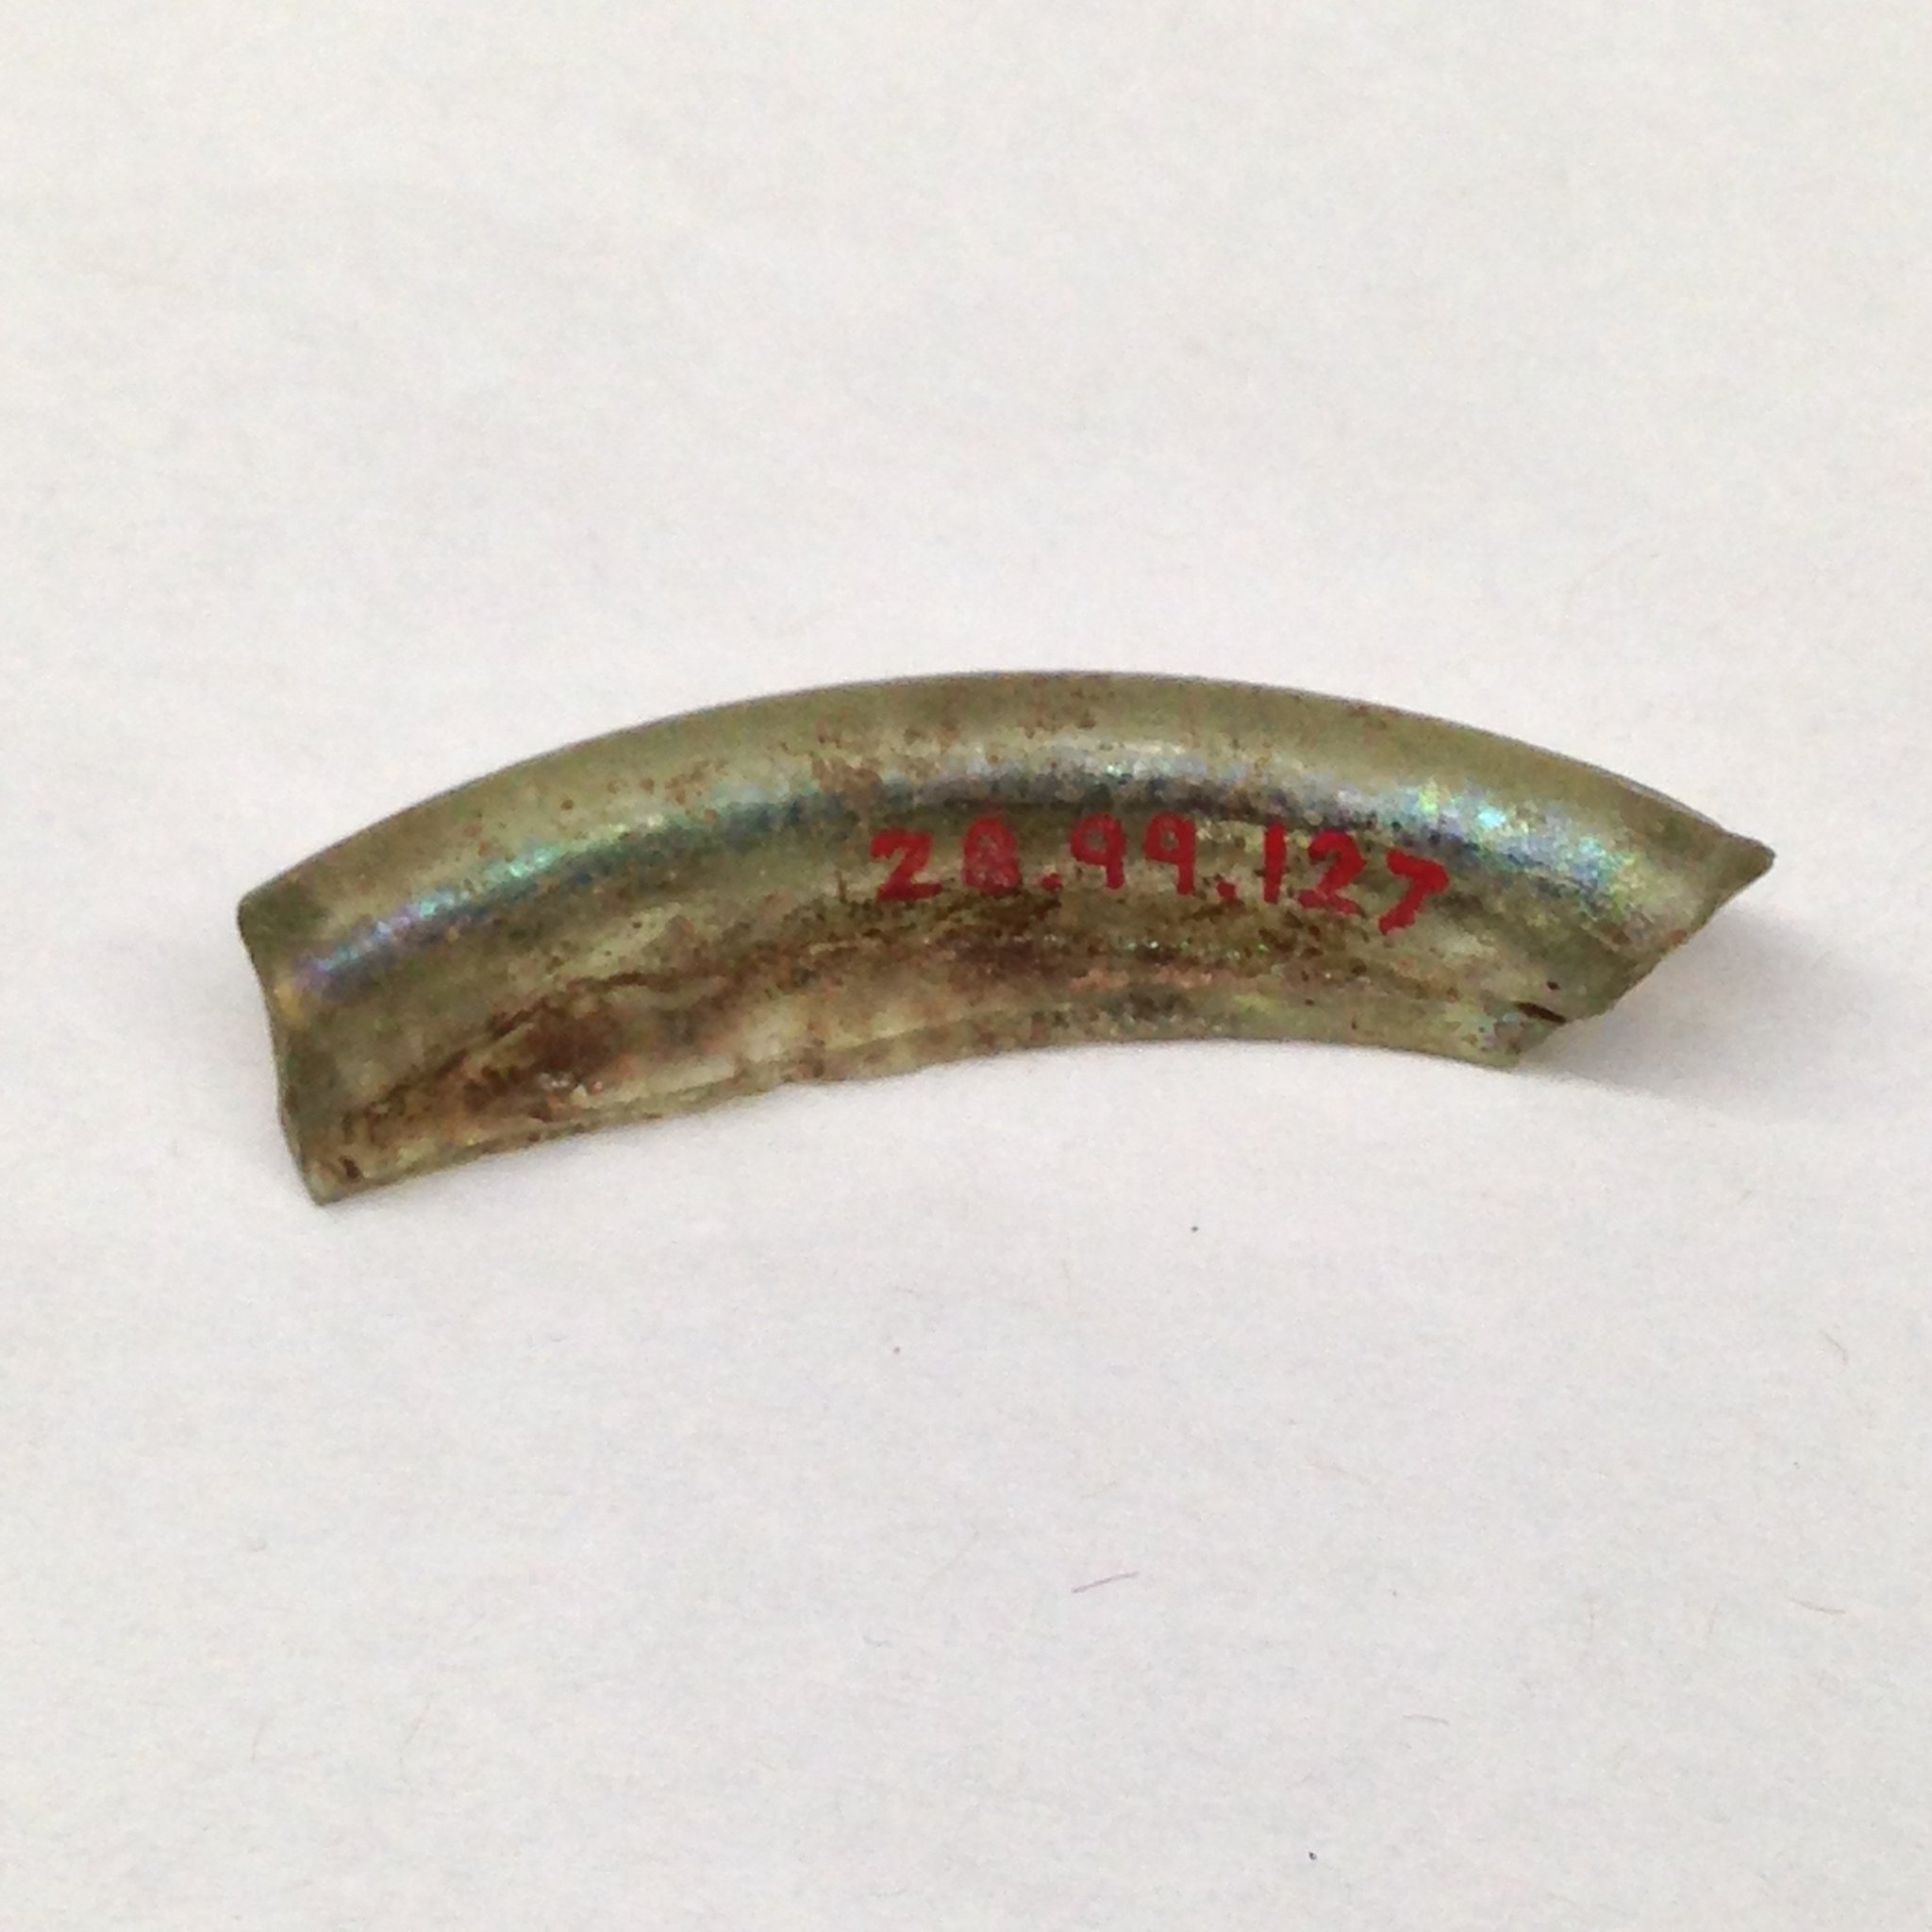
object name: fragment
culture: european or middle eastern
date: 1150-1250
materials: ceramic, glass